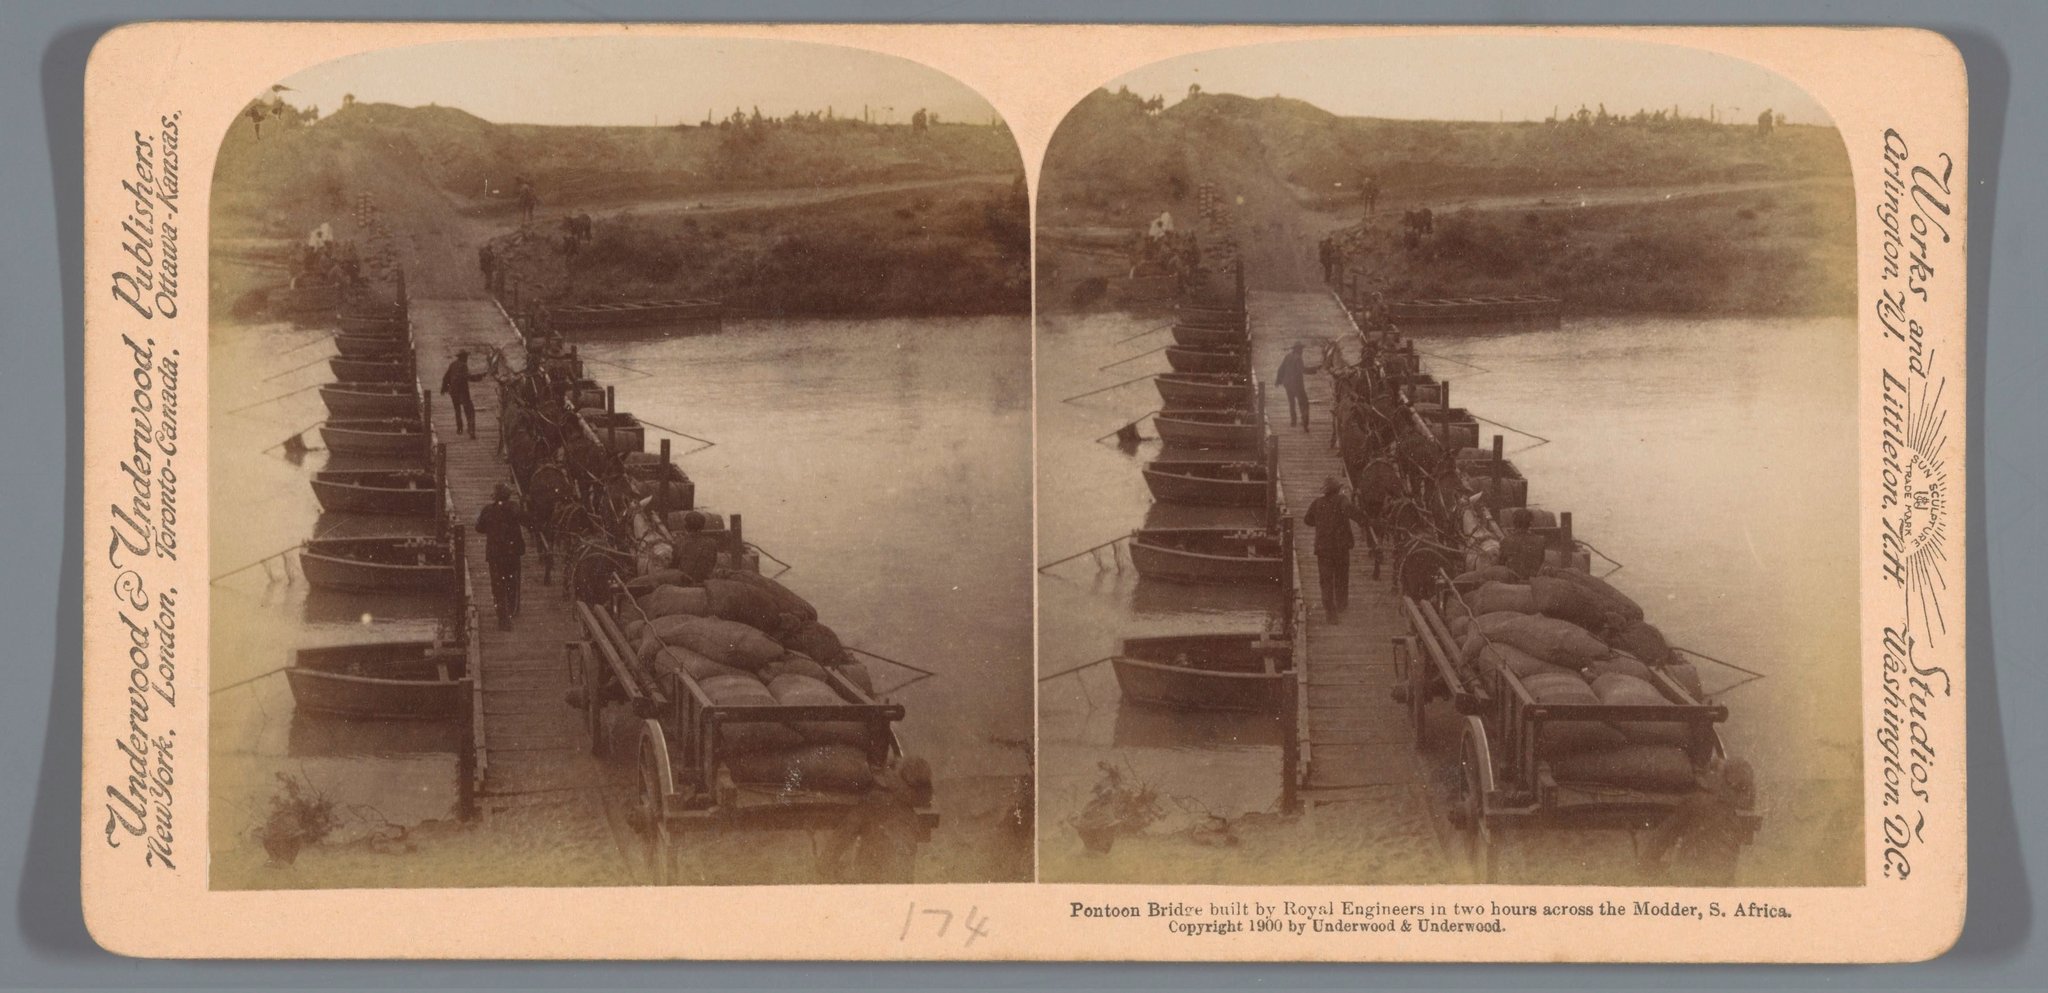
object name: stereograph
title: Pontoon Bridge built by Royal Engineers in two hours across the Modder, S. Africa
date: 1900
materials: cardboard, photographic support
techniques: albumen print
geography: south africa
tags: pontoon bridge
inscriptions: name: ‘Works and Studios Sun Sculpture trade mark Arlington N.J. Littleton N.H. Washington D.C.’, number: ‘174’